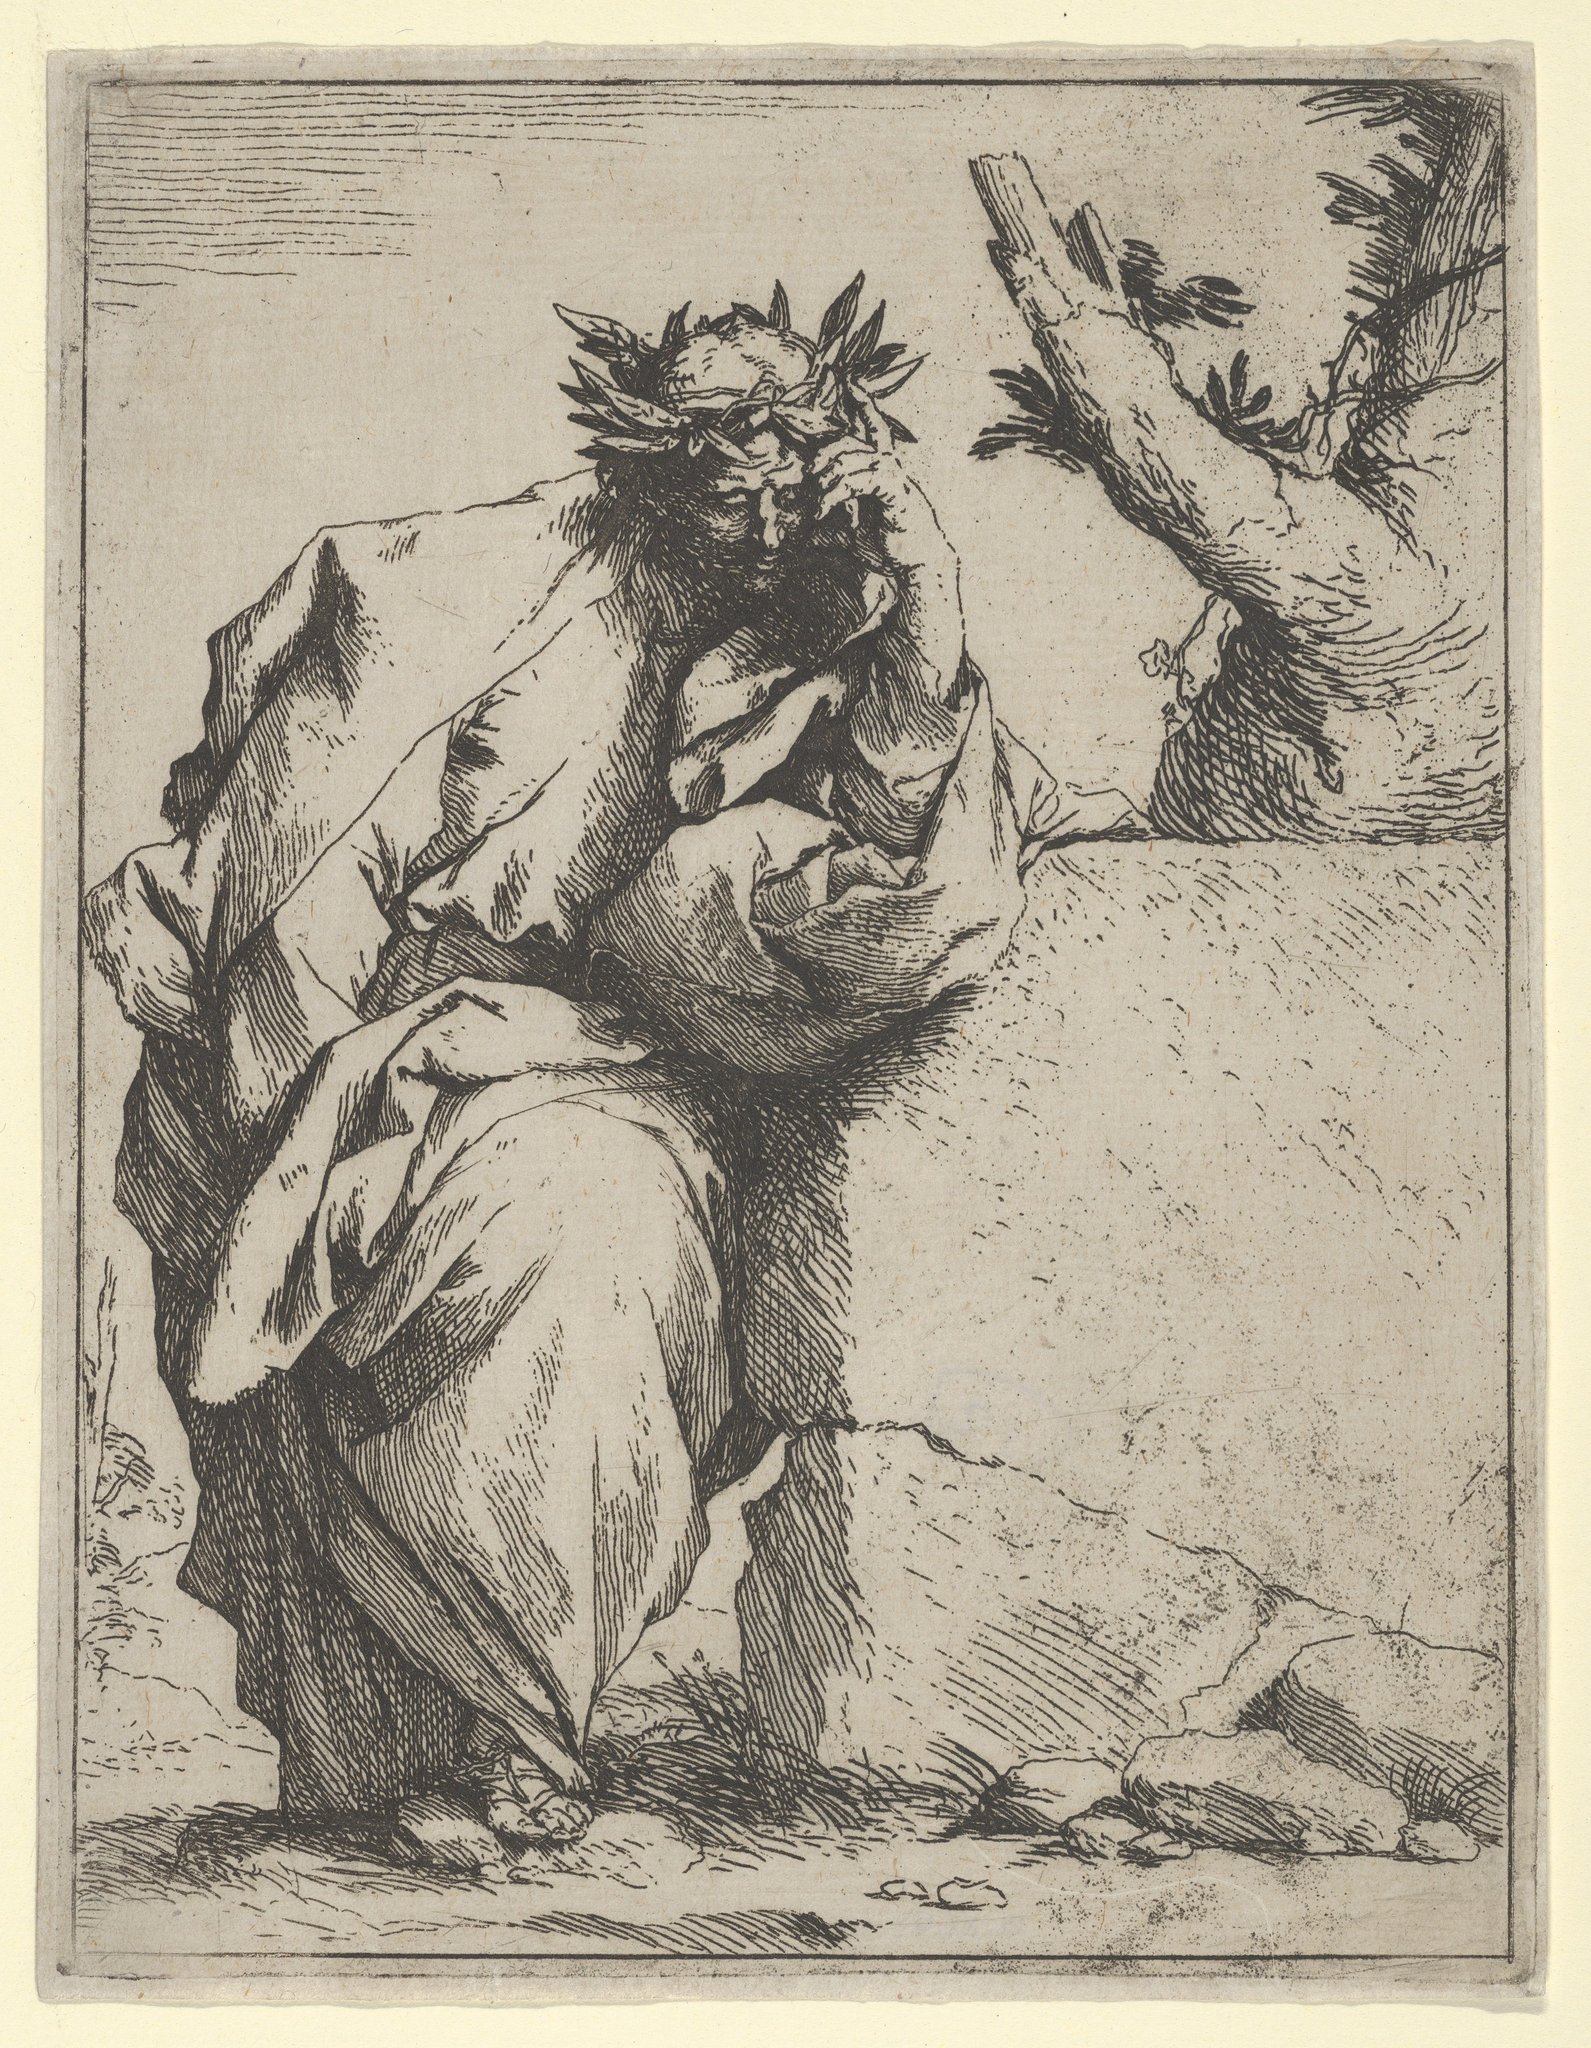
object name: print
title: The poet, standing crowned with laurel, leaning on a stone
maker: jusepe de ribera (called lo spagnoletto)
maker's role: artist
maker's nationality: spanish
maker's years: 1591-1652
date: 1620-1621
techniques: etching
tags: men,poets,authors